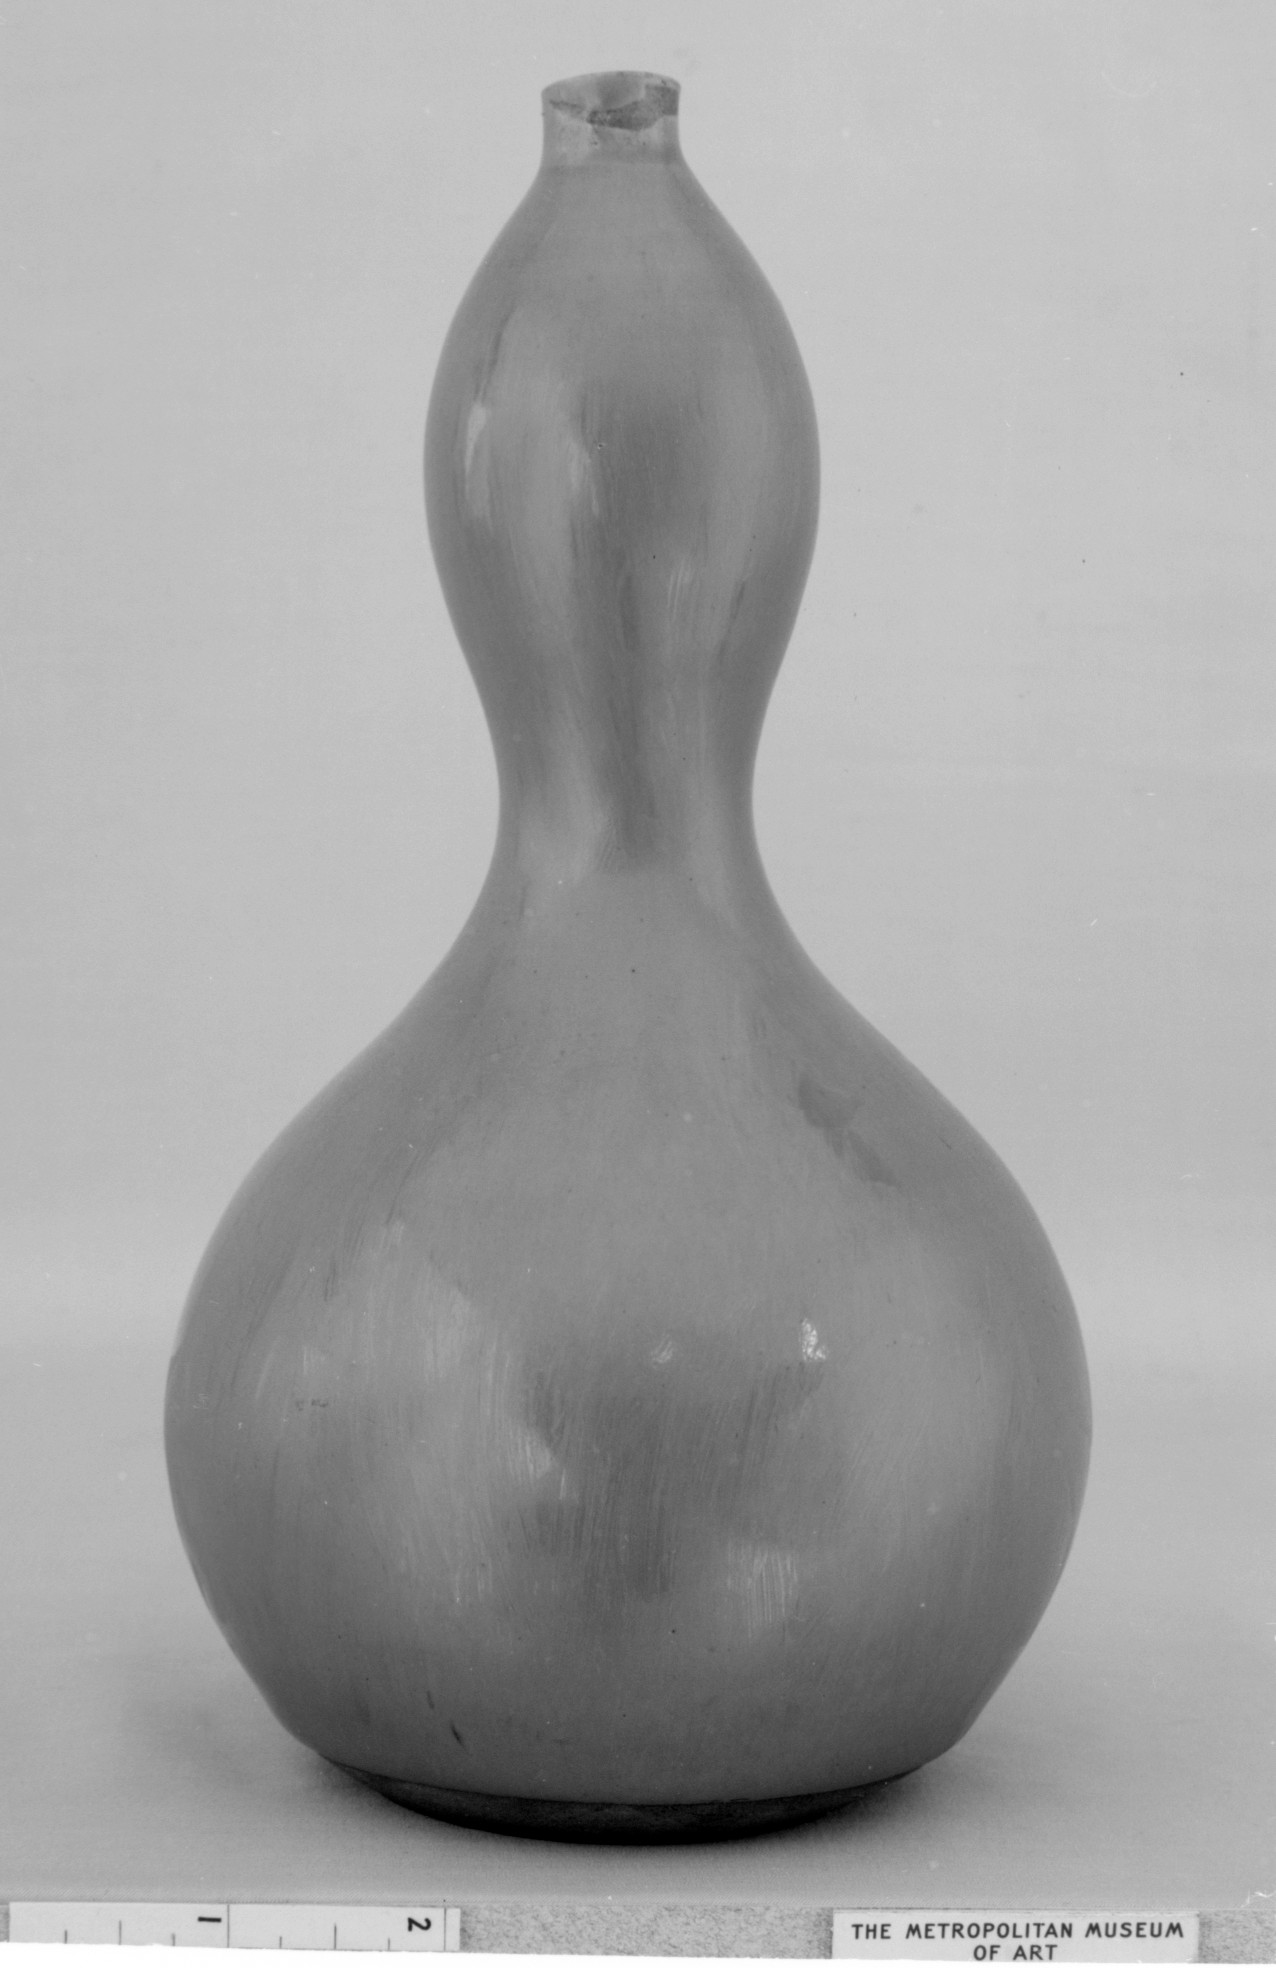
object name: bottle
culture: japanese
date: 1801-1900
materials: clay, glaze